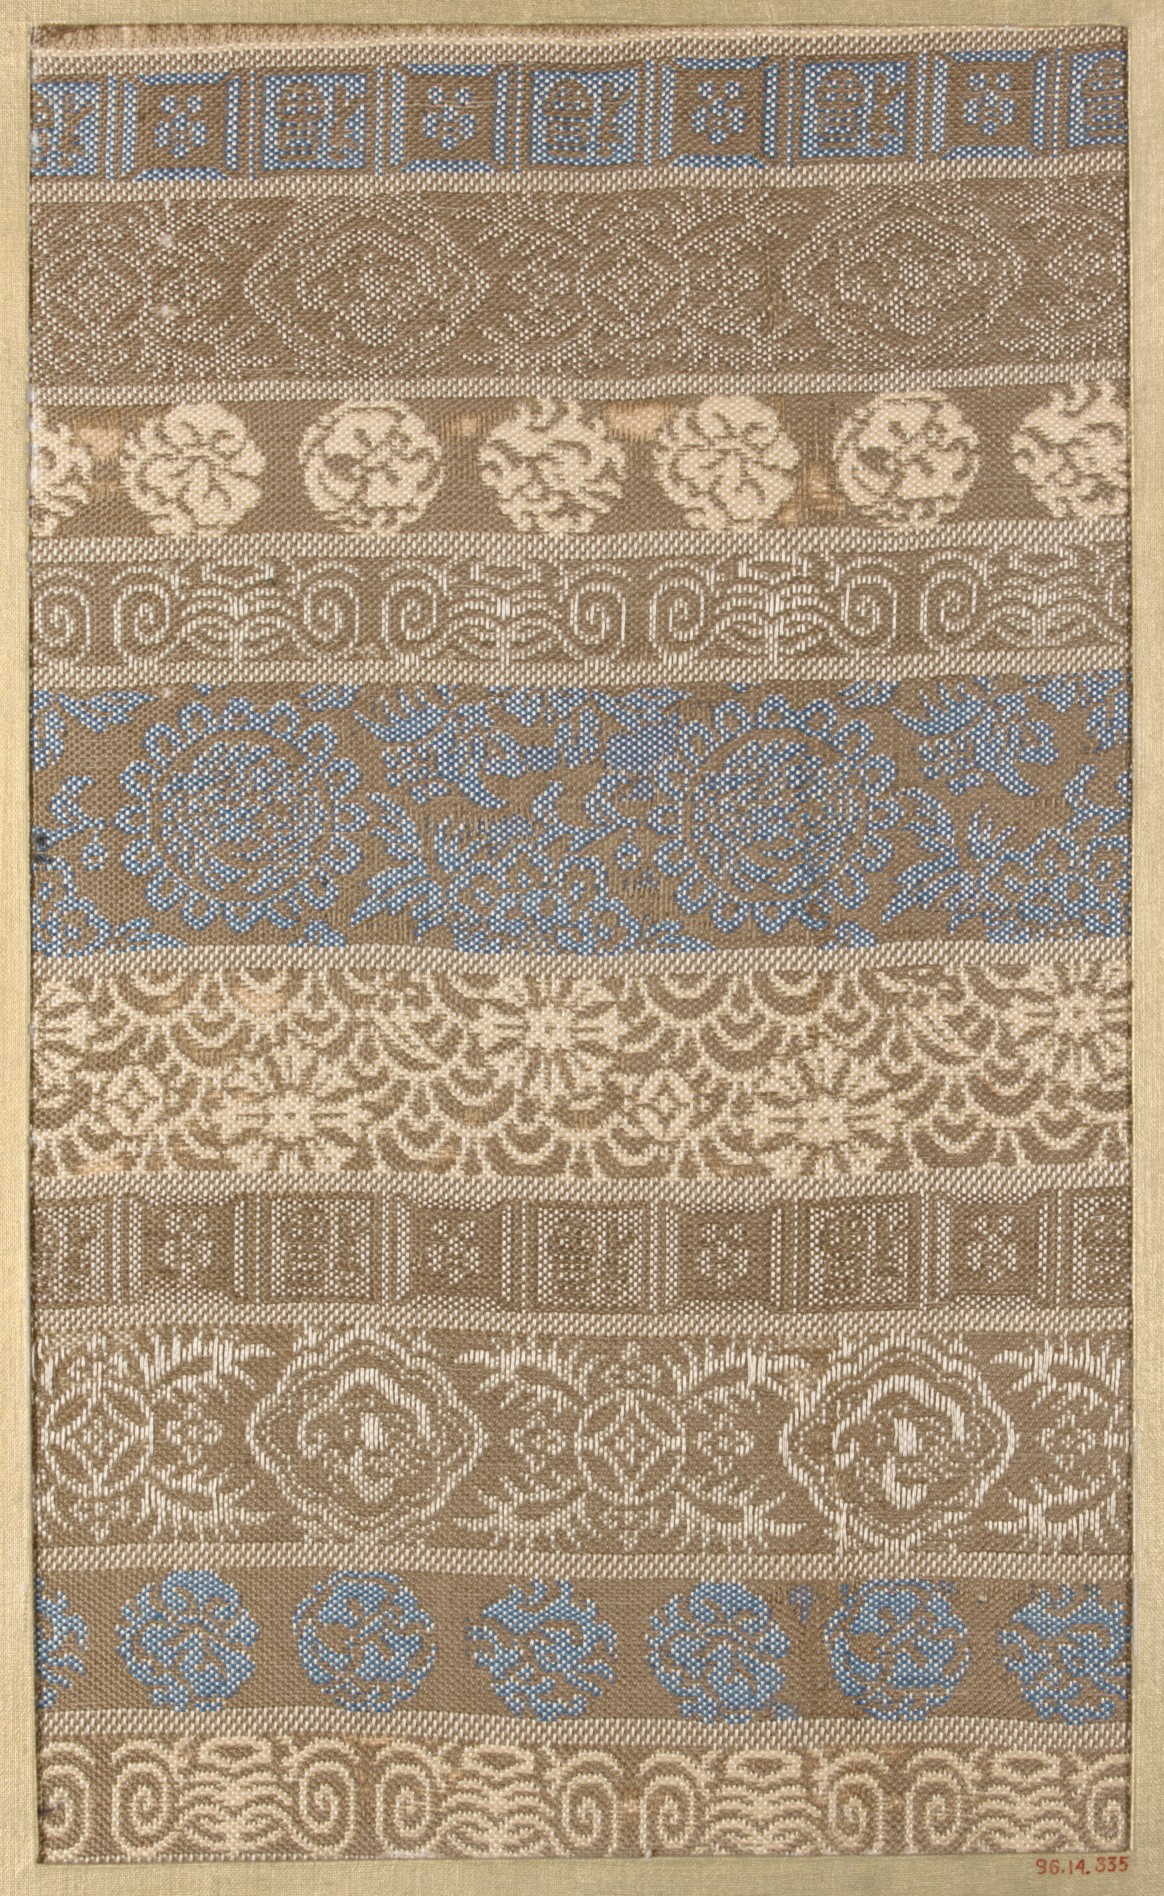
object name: piece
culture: japanese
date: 1701-1900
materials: silk